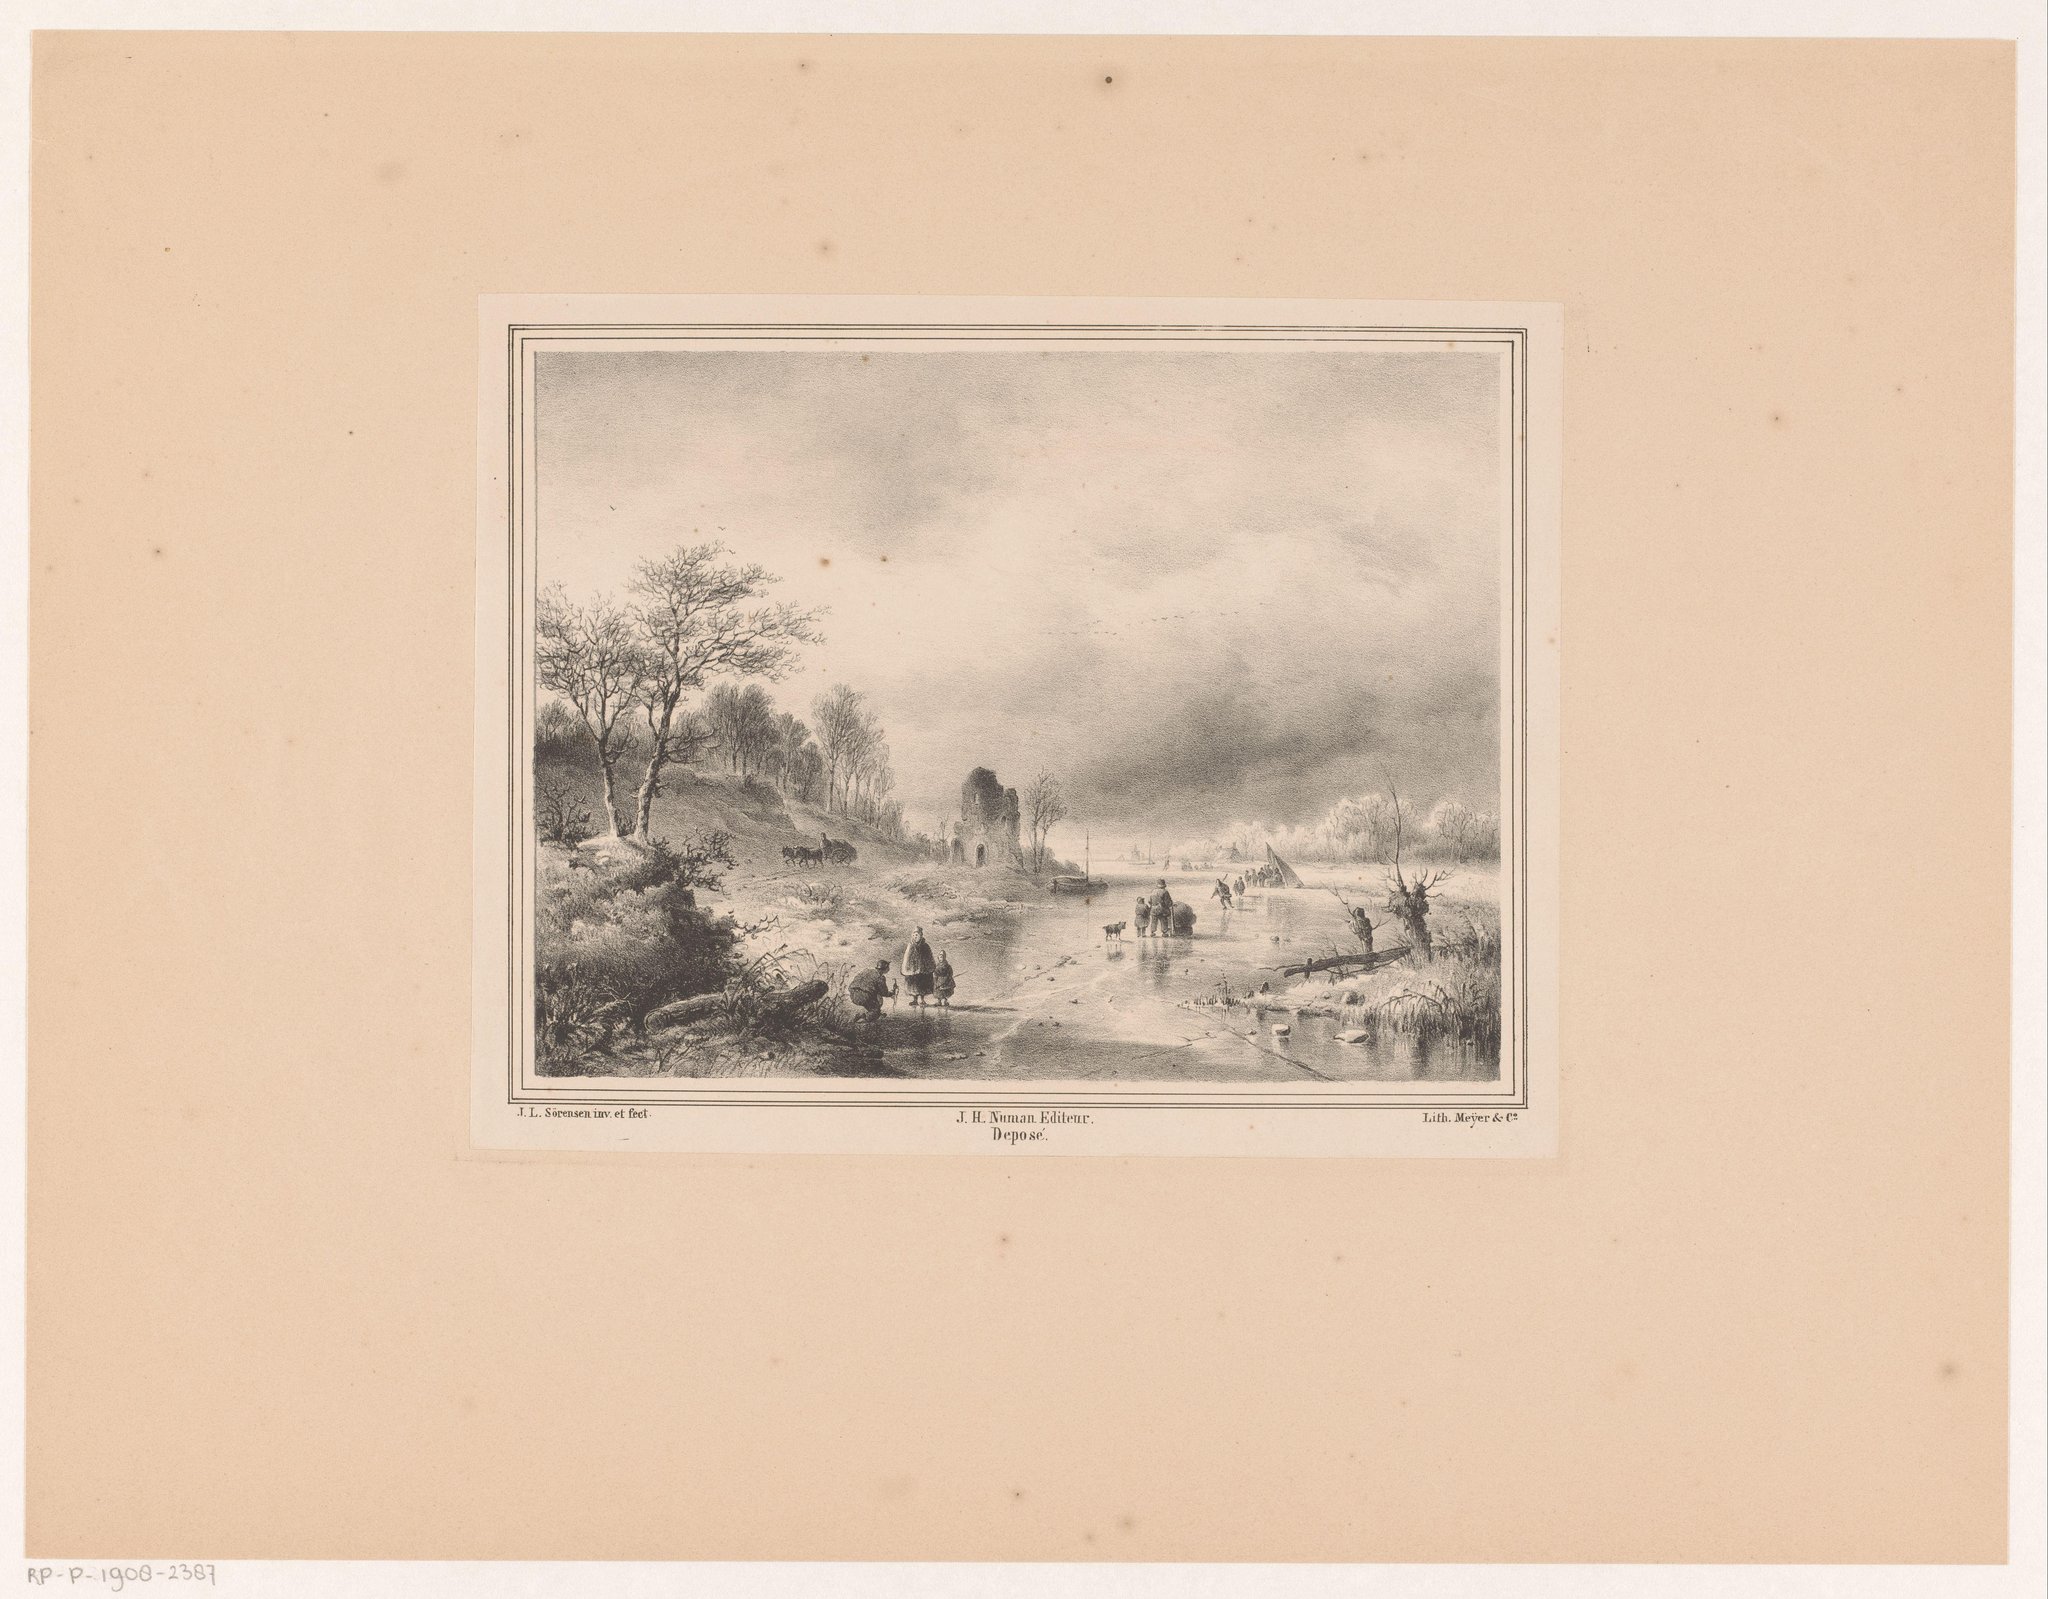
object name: print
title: Figuren op bevroren rivier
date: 1843-1856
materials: paper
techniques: lithograph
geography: amsterdam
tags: river, sleigh, sledge (non-sport), skates (winter sports)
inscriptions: : ‘Deposé.’, collector's mark: Lugt 2228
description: Schaatsers en figuren met een slee op een bevroren rivier. In de achtergrond tenten op het ijs waarbij mensen staan. Links rijden paarden met een wagen op een pad bij een ruïne.